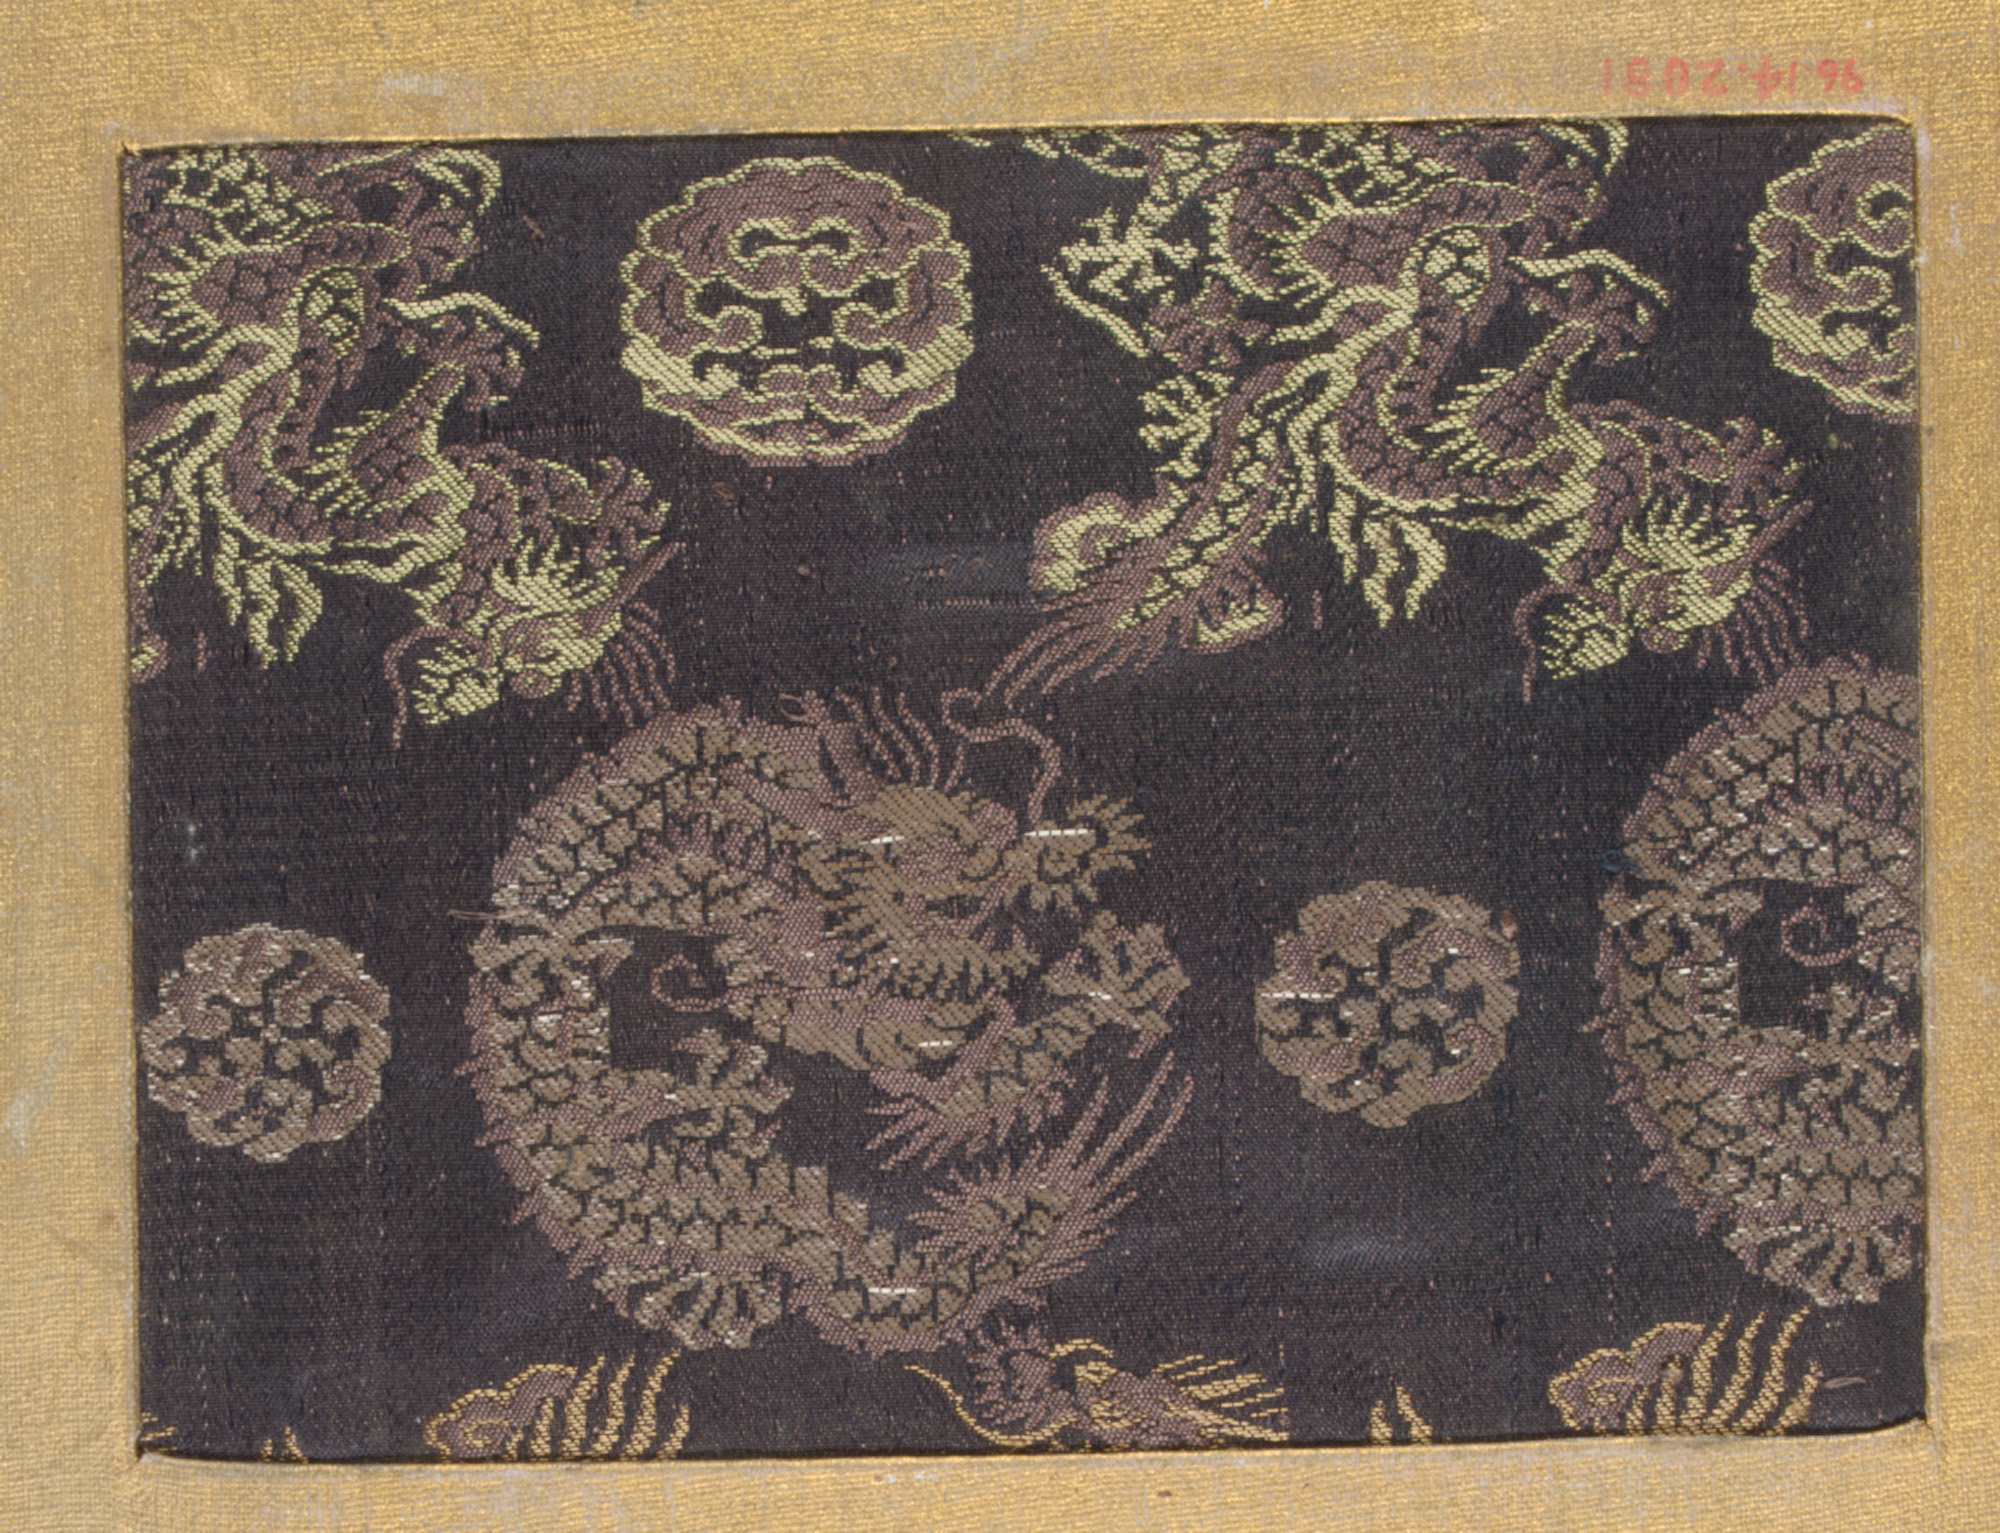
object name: piece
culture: japanese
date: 1701-1900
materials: silk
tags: dragons